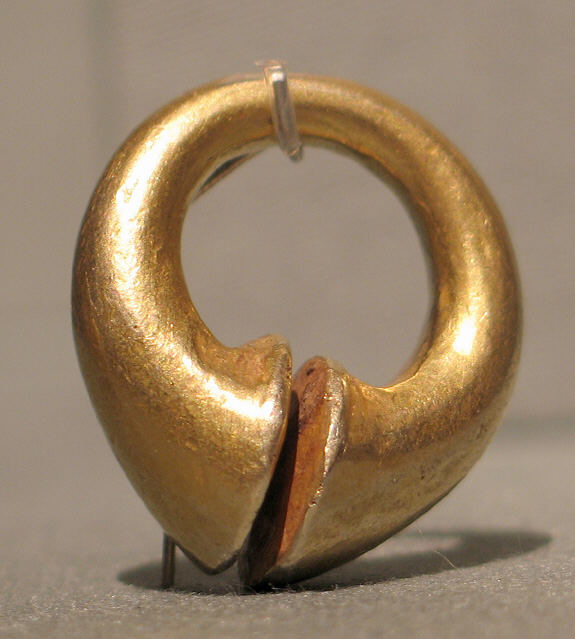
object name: earring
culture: indonesian, javanese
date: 701-833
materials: gold